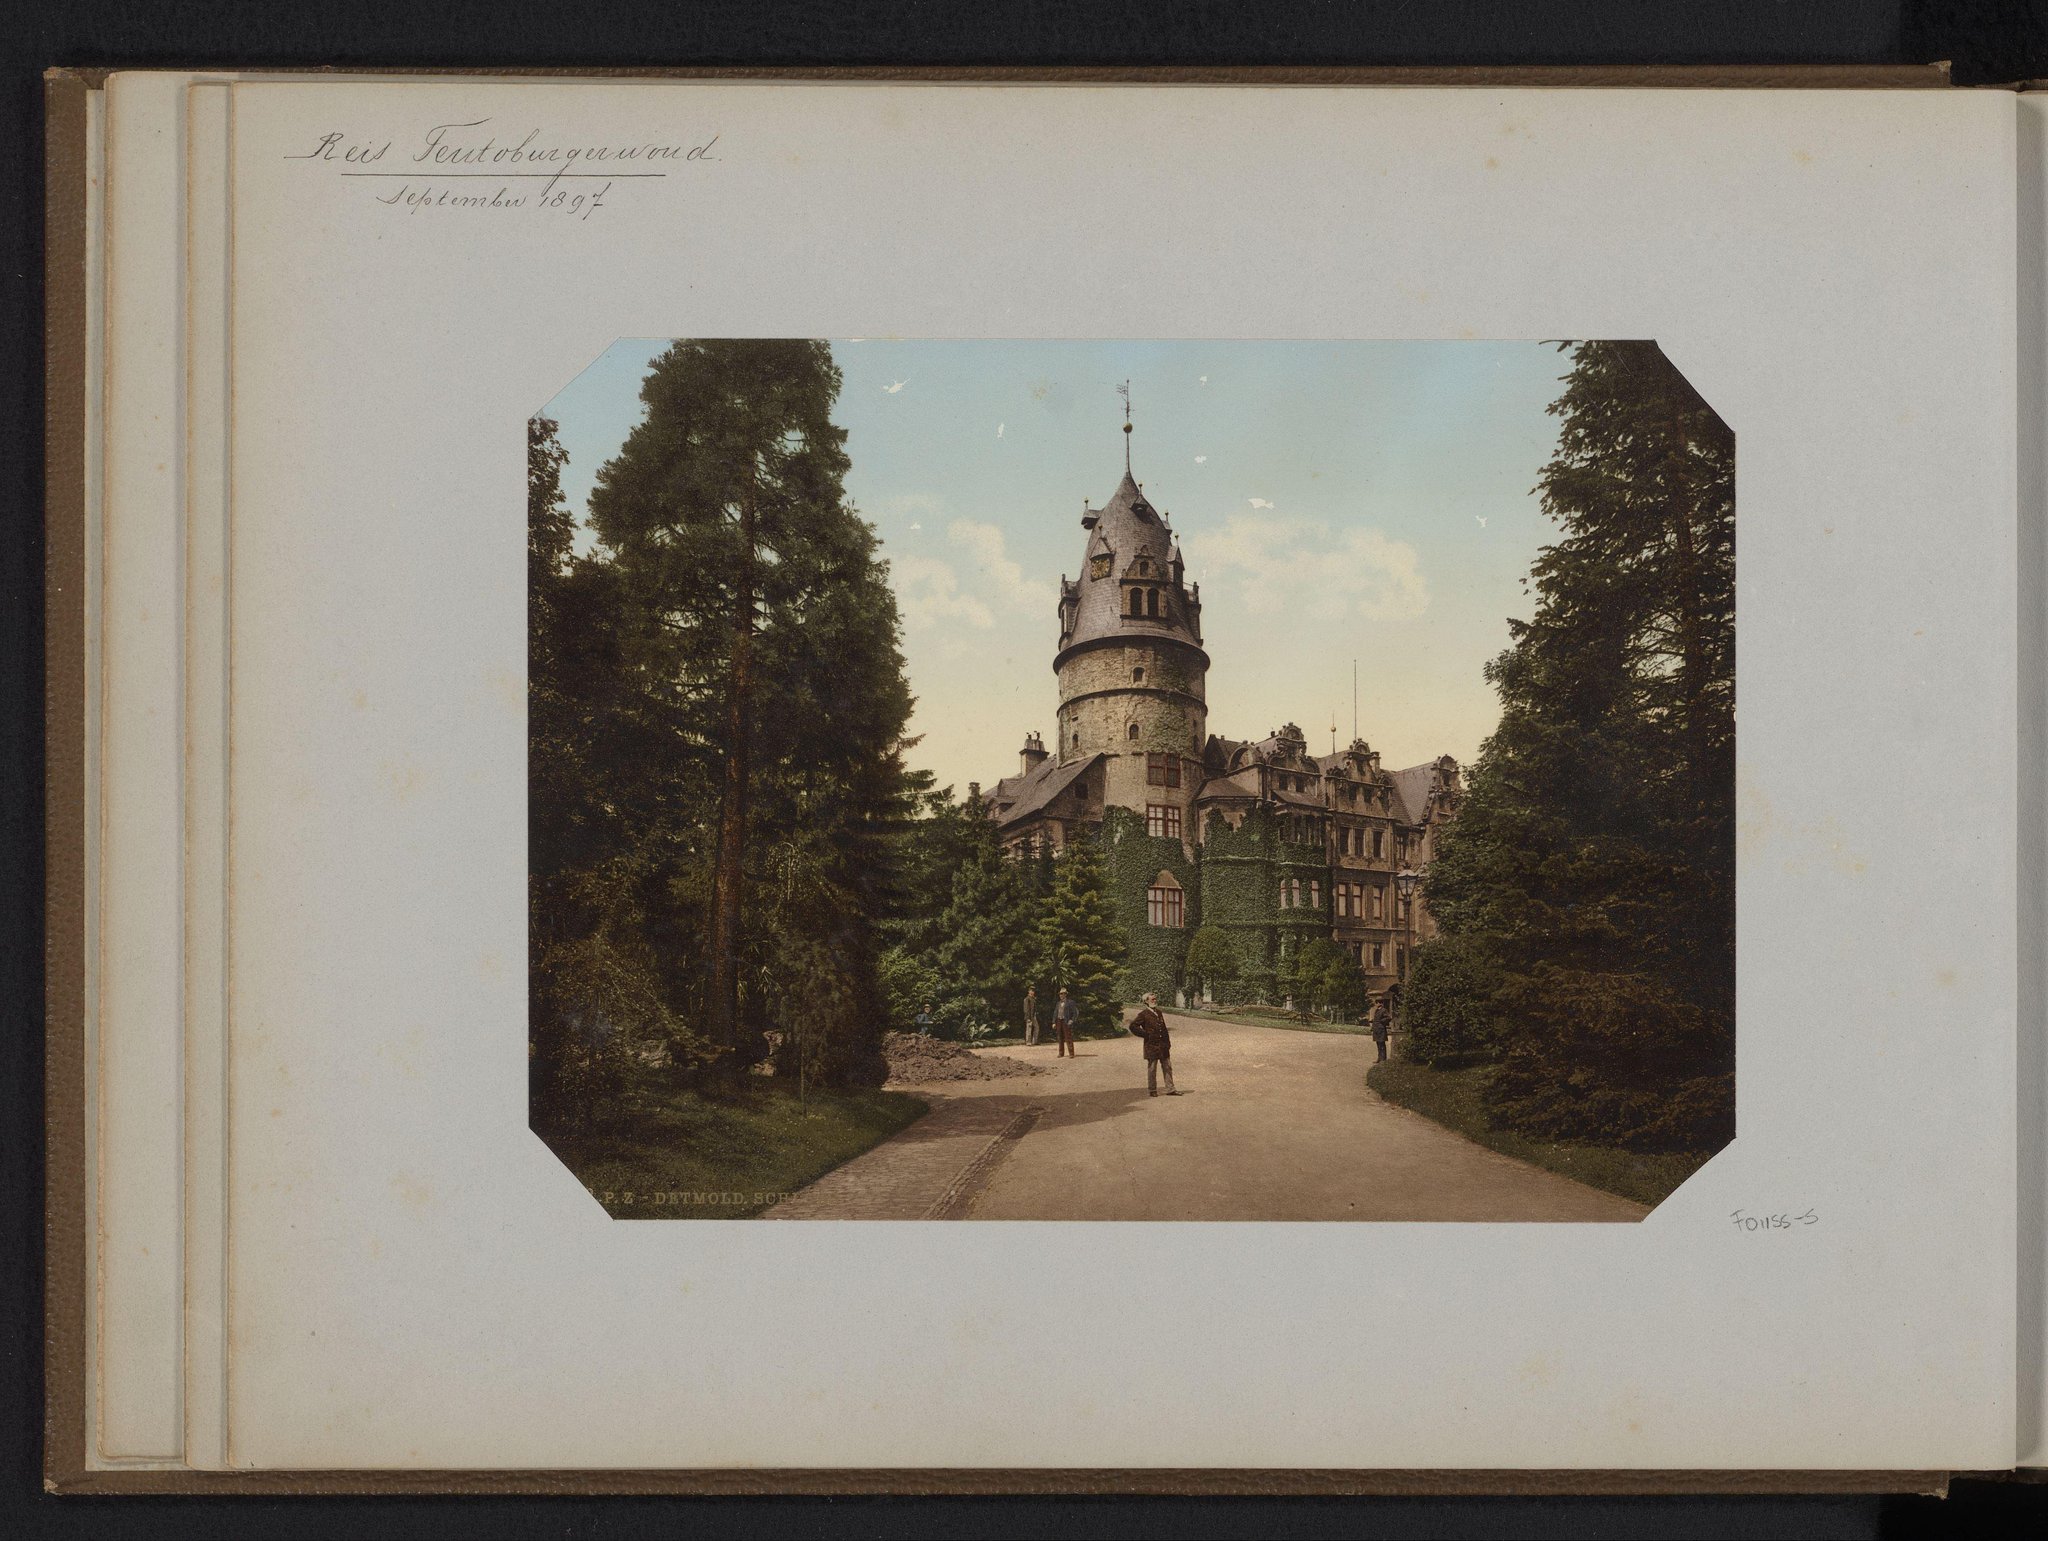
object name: photomechanical print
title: Gezicht op Schloss Detmold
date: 1890-1897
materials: paper, photographic process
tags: landscape with tower or castle (+ city(-scape) with figures, staffage)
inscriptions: annotation: ‘Reis Teutoburgerwald/ september 1897’, inscription: ‘1992. P.Z. - Detmold. Schloss’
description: Deze prent maakt deel uit van een album.